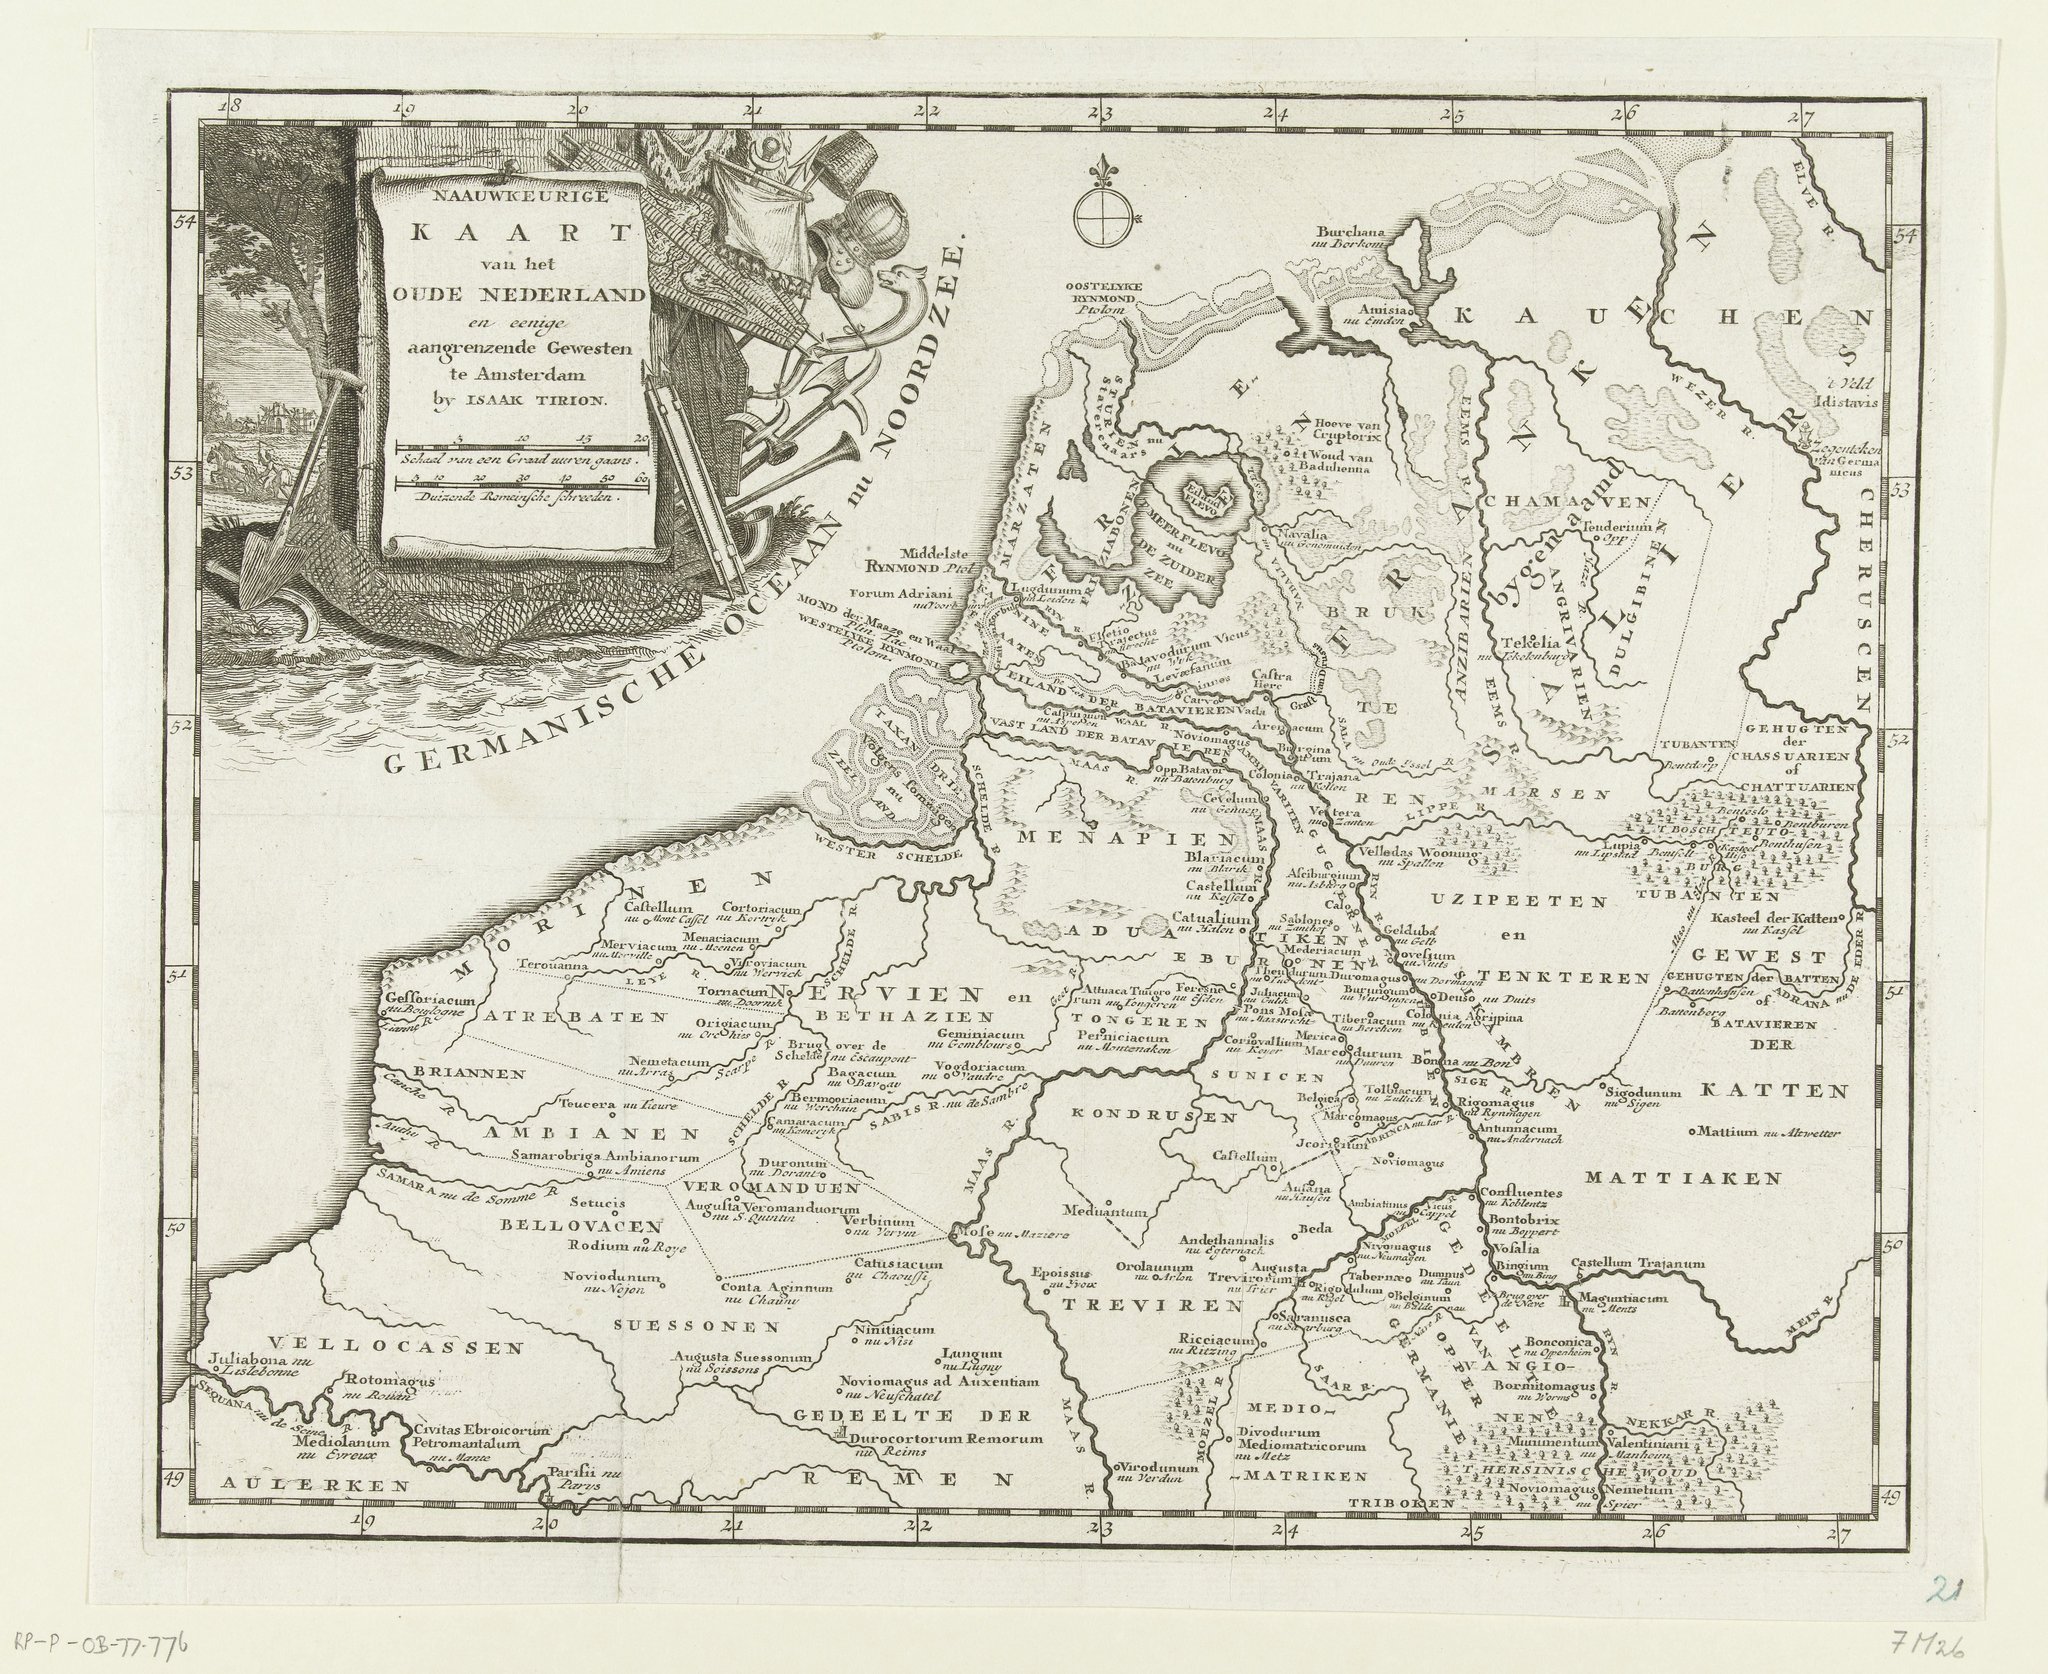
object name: history print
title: Naauwkeurige Kaart van het Oude Nederland en eenige aangrenzende Gewesten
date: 1747-1759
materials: paper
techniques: engraving, etching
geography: amsterdam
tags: maps of separate countries or regions, netherlands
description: Kaart van de Nederlanden ten tijde van de Bataven. Linksboven een cartouche met de titel versierd met attributen van de visserij, jacht en landbouw.